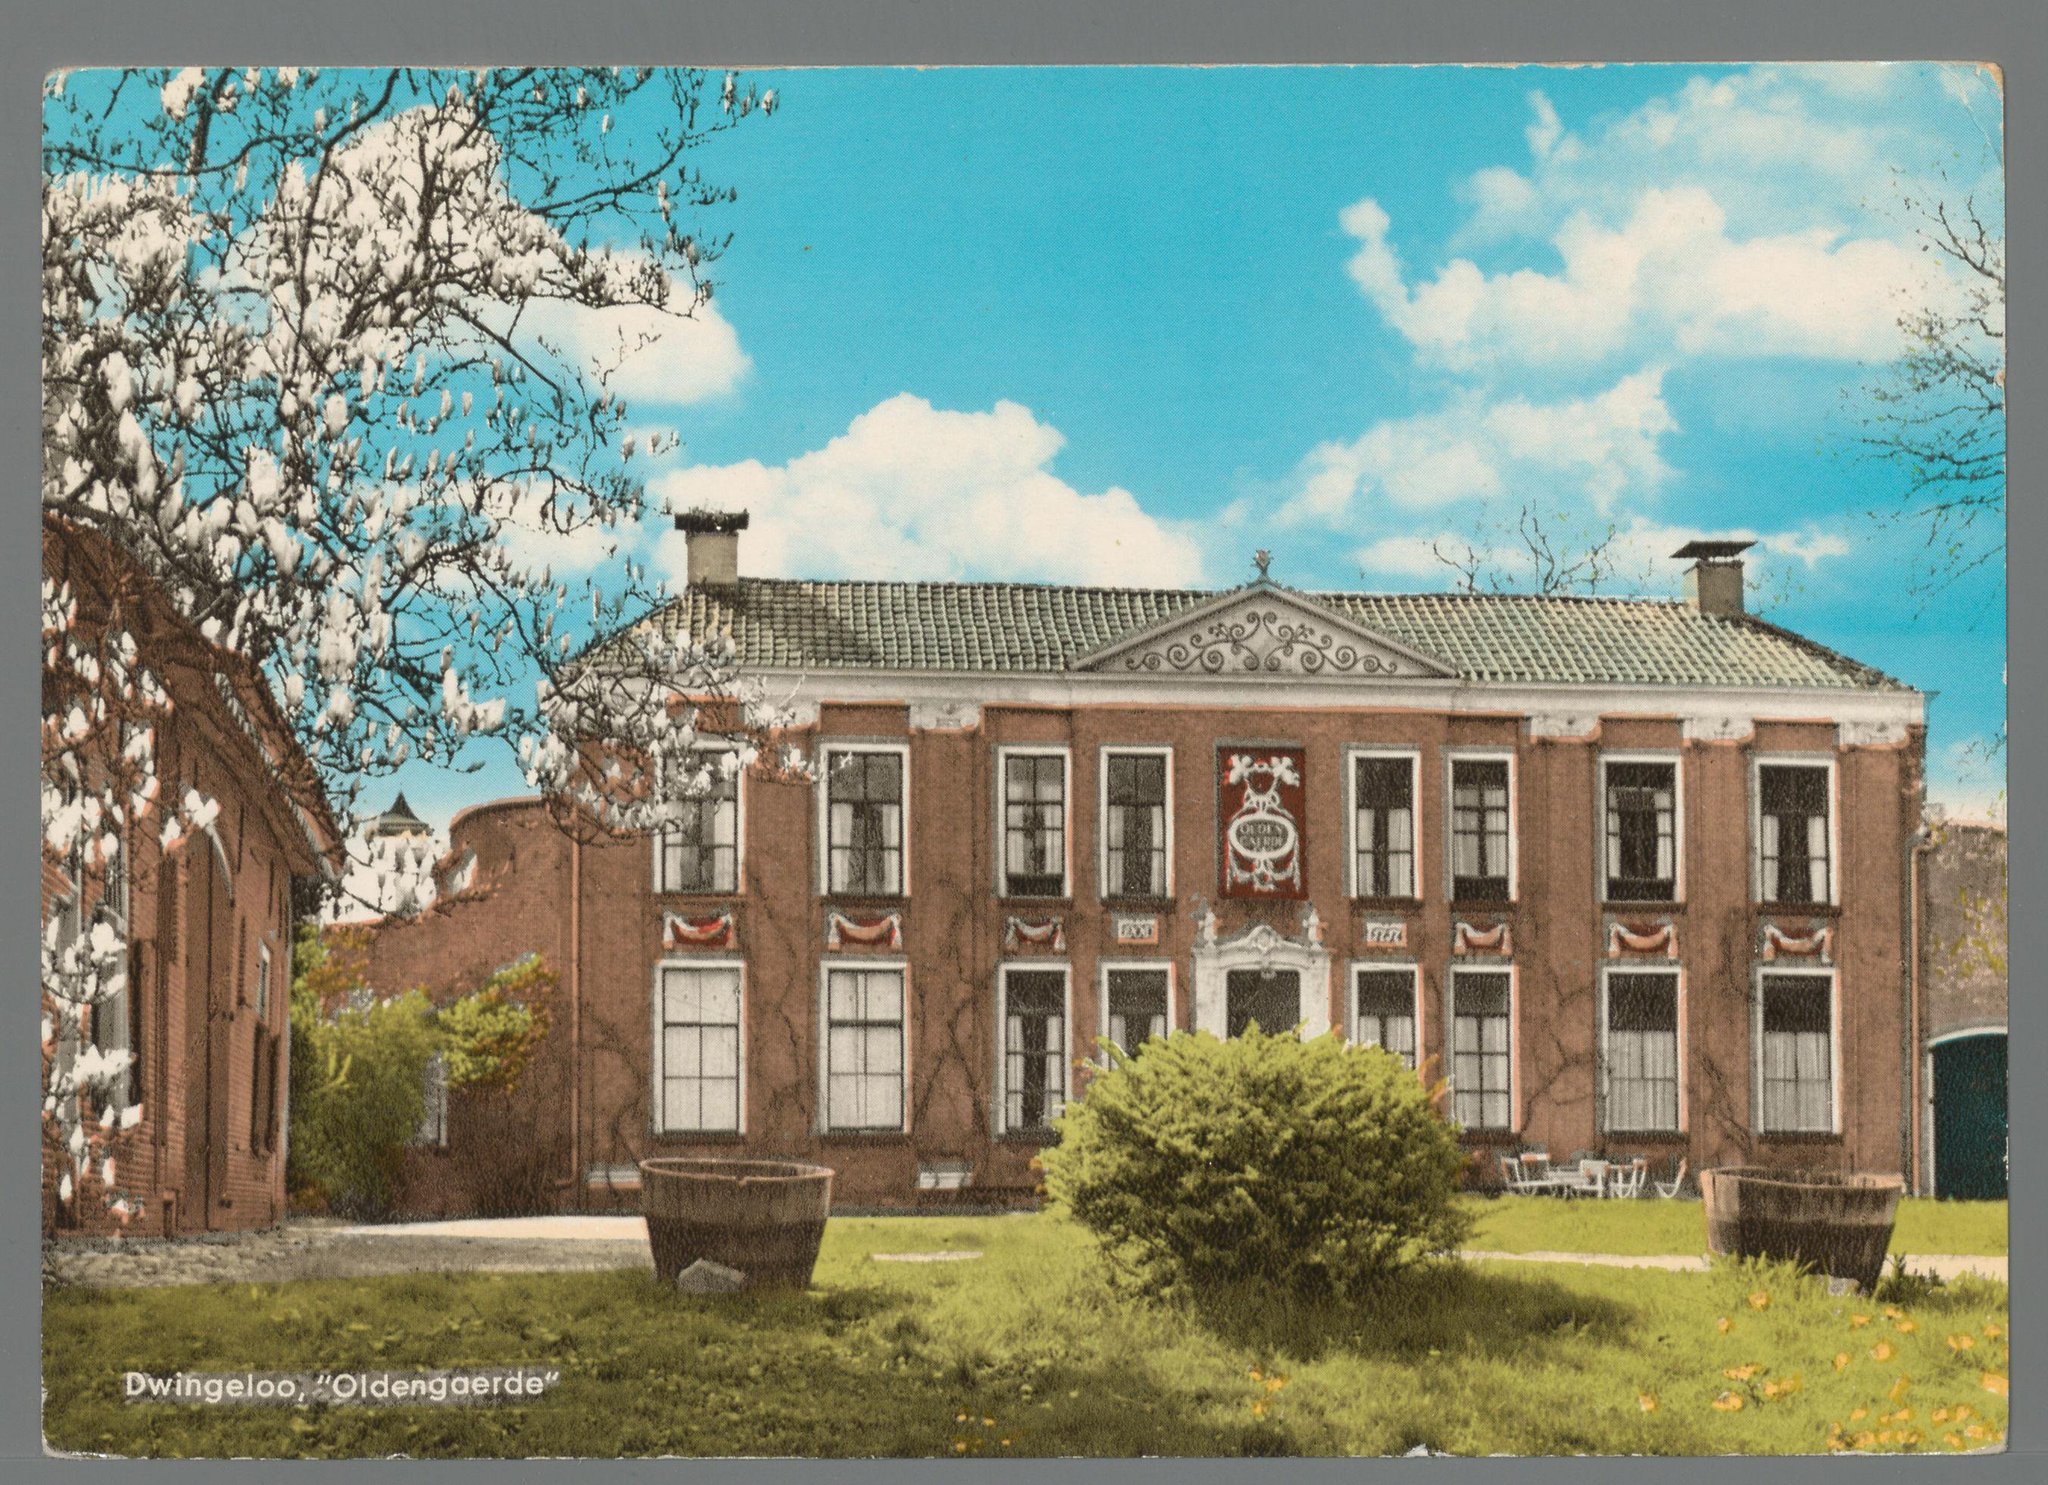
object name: photomechanical print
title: Dwingeloo, "Oldengaerde"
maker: Anonymous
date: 1909-1965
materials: cardboard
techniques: printing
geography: sneek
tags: rural housing, e.g. country-house, villa, cottage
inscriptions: poststempel, verso, gestempeld